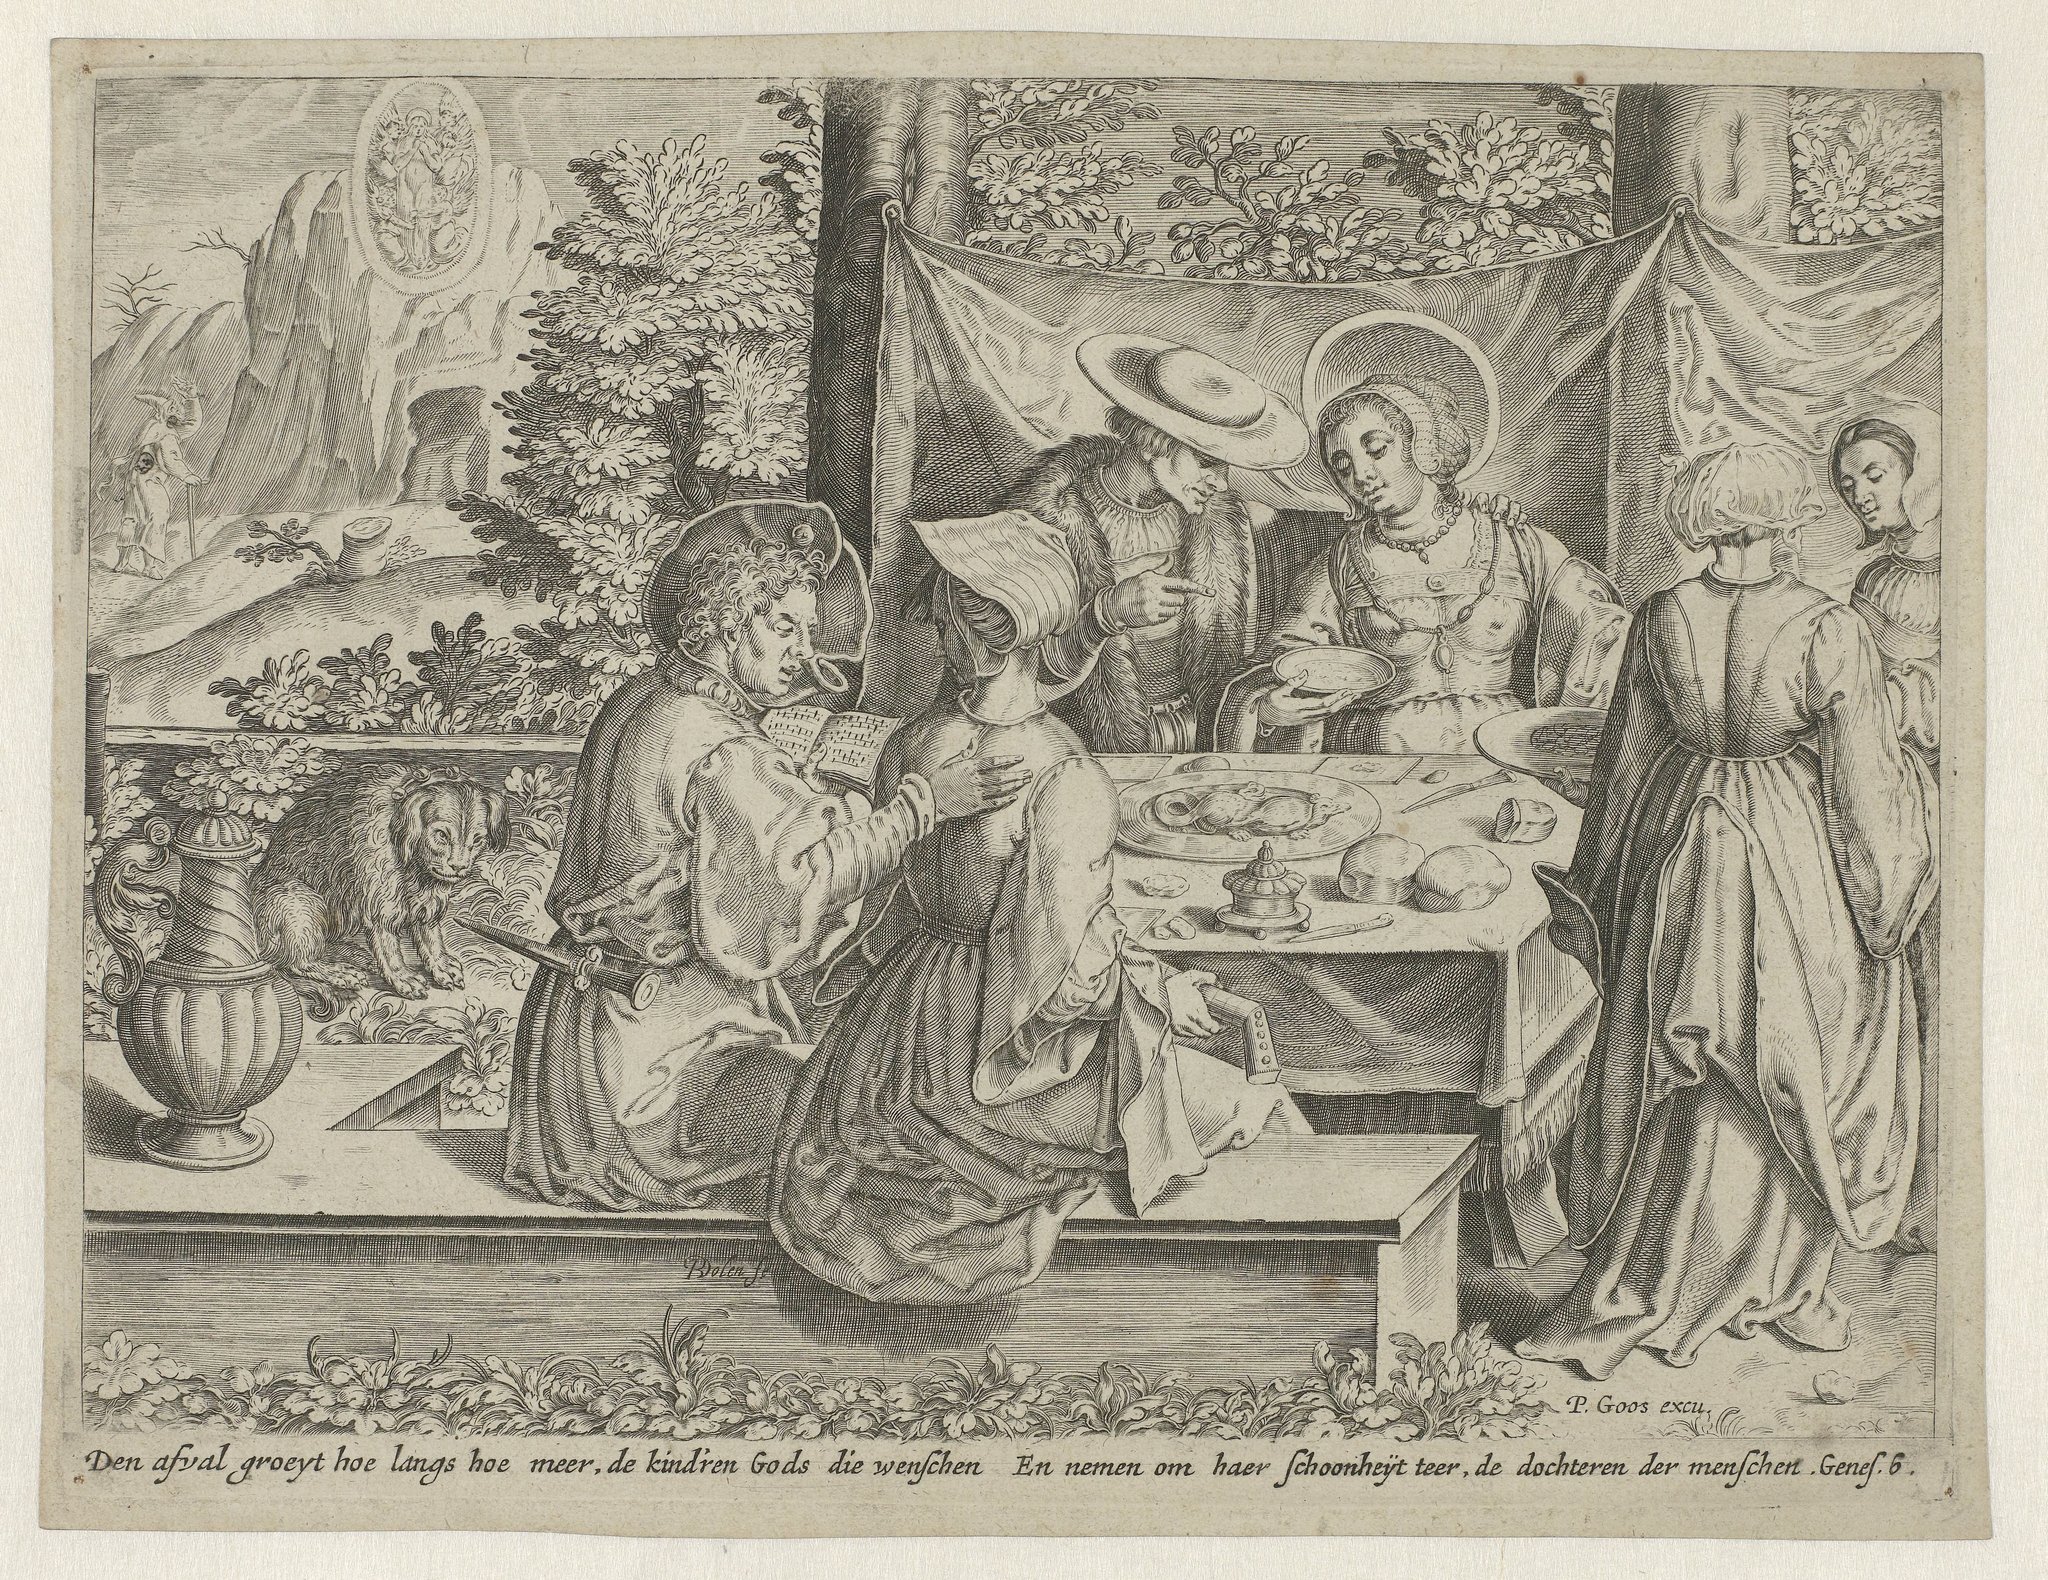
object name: print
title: Vrolijk gezelschap aan tafel (Het wereldse leven van Maria Magdalena)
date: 1580-1620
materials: paper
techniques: engraving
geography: northern netherlands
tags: head-gear: hat (+ men's clothes), head-gear: cap (+ women's clothes), dress, gown (+ women's clothes), life of st. mary magdalene before her conversion, e.g. dancing, hunting, vocal music, singing - cc - out of doors, private festivities, merry company - aa - in the open air, 'fête champêtre', dog, lute, and special forms of lute, e.g.: theorbo - cc - out of doors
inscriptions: caption: ‘Den afval groeyt hoe langs hoe meer, de kind'ren Gods die wenschen En nemen om haer schoonheijt teer, de dochteren der menschen. Genes. 6’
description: Maria Magdalena is voorgesteld in een vroeg 16de-eeuws kostuum, een halo om het hoofd. Zij zit aan een tafel met voedsel, in gezelschap van twee mannen en een vrouw. Naast de tafel staan twee diensters. De zittende vrouw speelt luit, terwijl een man een liedboek vasthoudt en zingt. In de achtergrond is de ten hemel opneming van Maria Magdalena voorgesteld in een rotsachtig landschap. Met onderschrift uit Genesis 6.